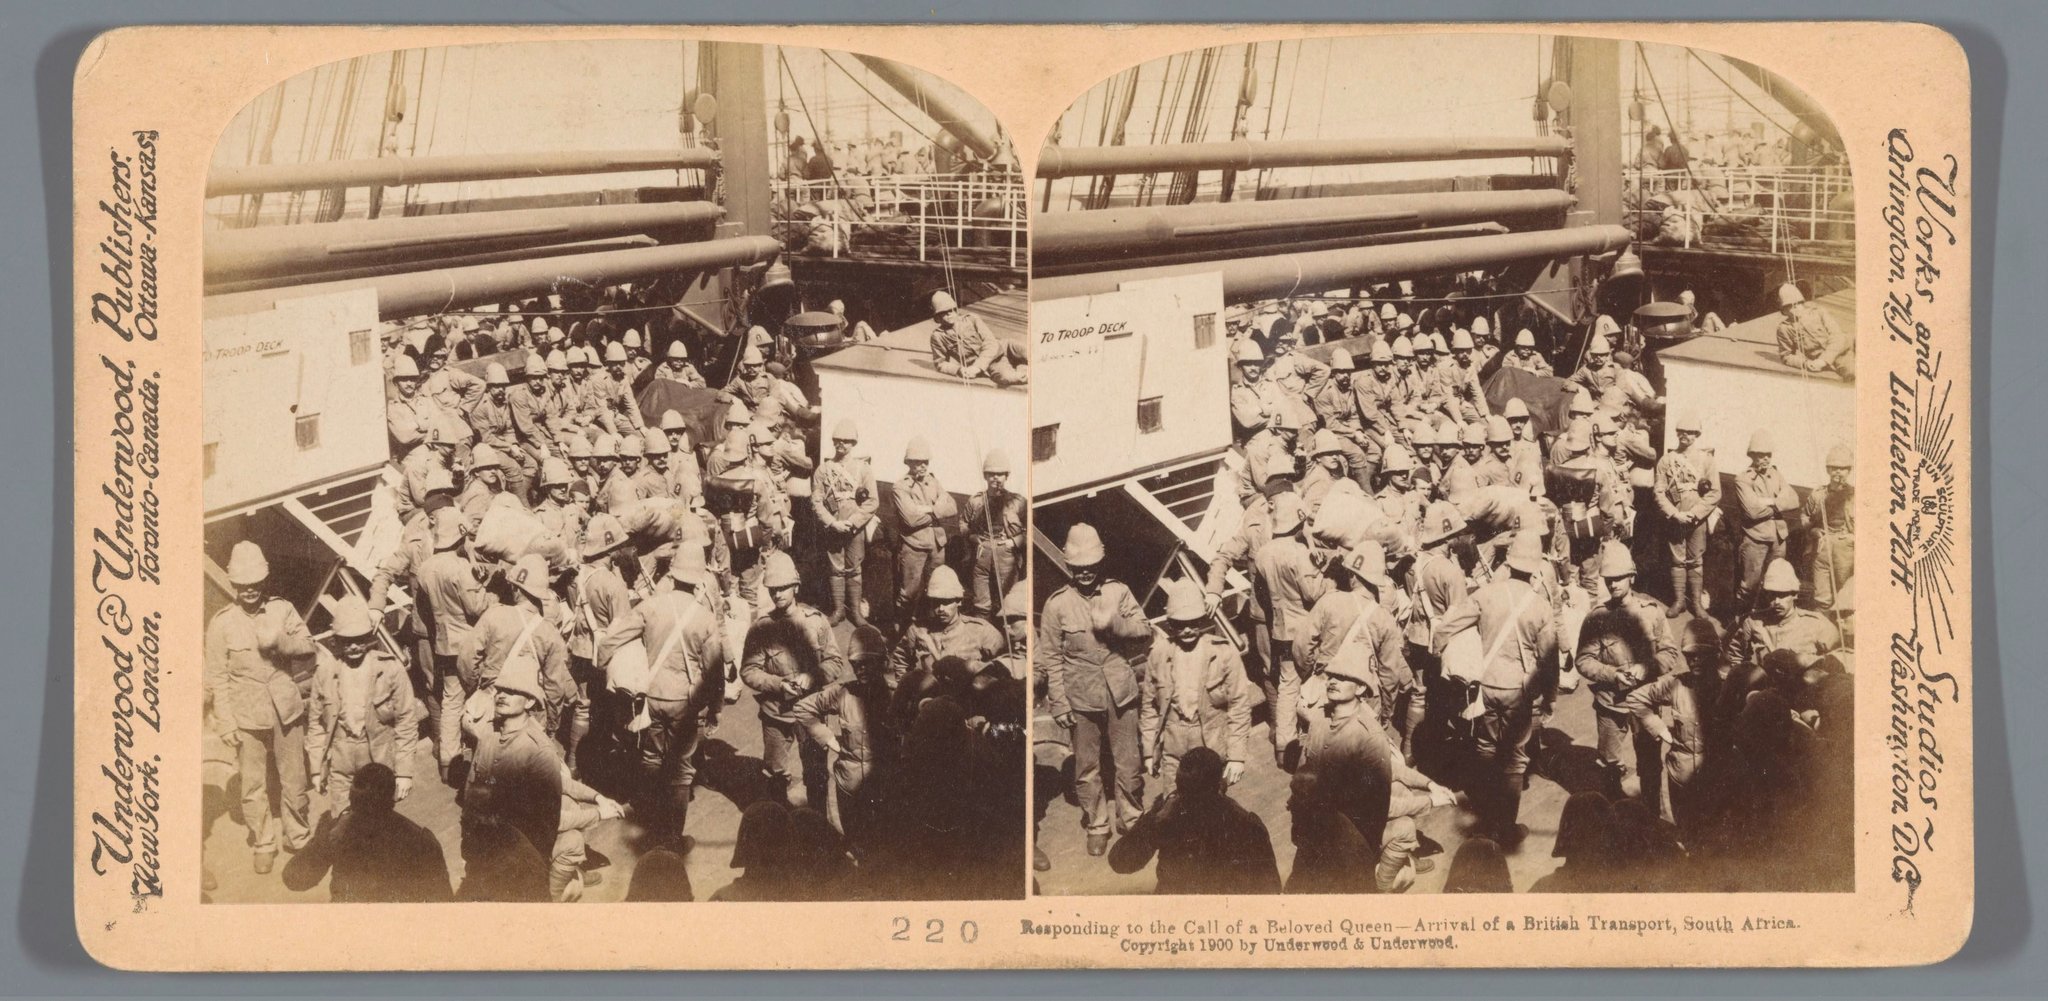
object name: stereograph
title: Responding to the Call of a Beloved Queen - Arrival of a British Transport, South Africa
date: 1900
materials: cardboard, photographic support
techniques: albumen print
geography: south africa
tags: ships (in general), the soldier; the soldier's life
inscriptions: number: ‘220’, name: ‘Works and Studios Sun Sculpture trade mark Arlington N.J. Littleton N.H. Washington D.C.’